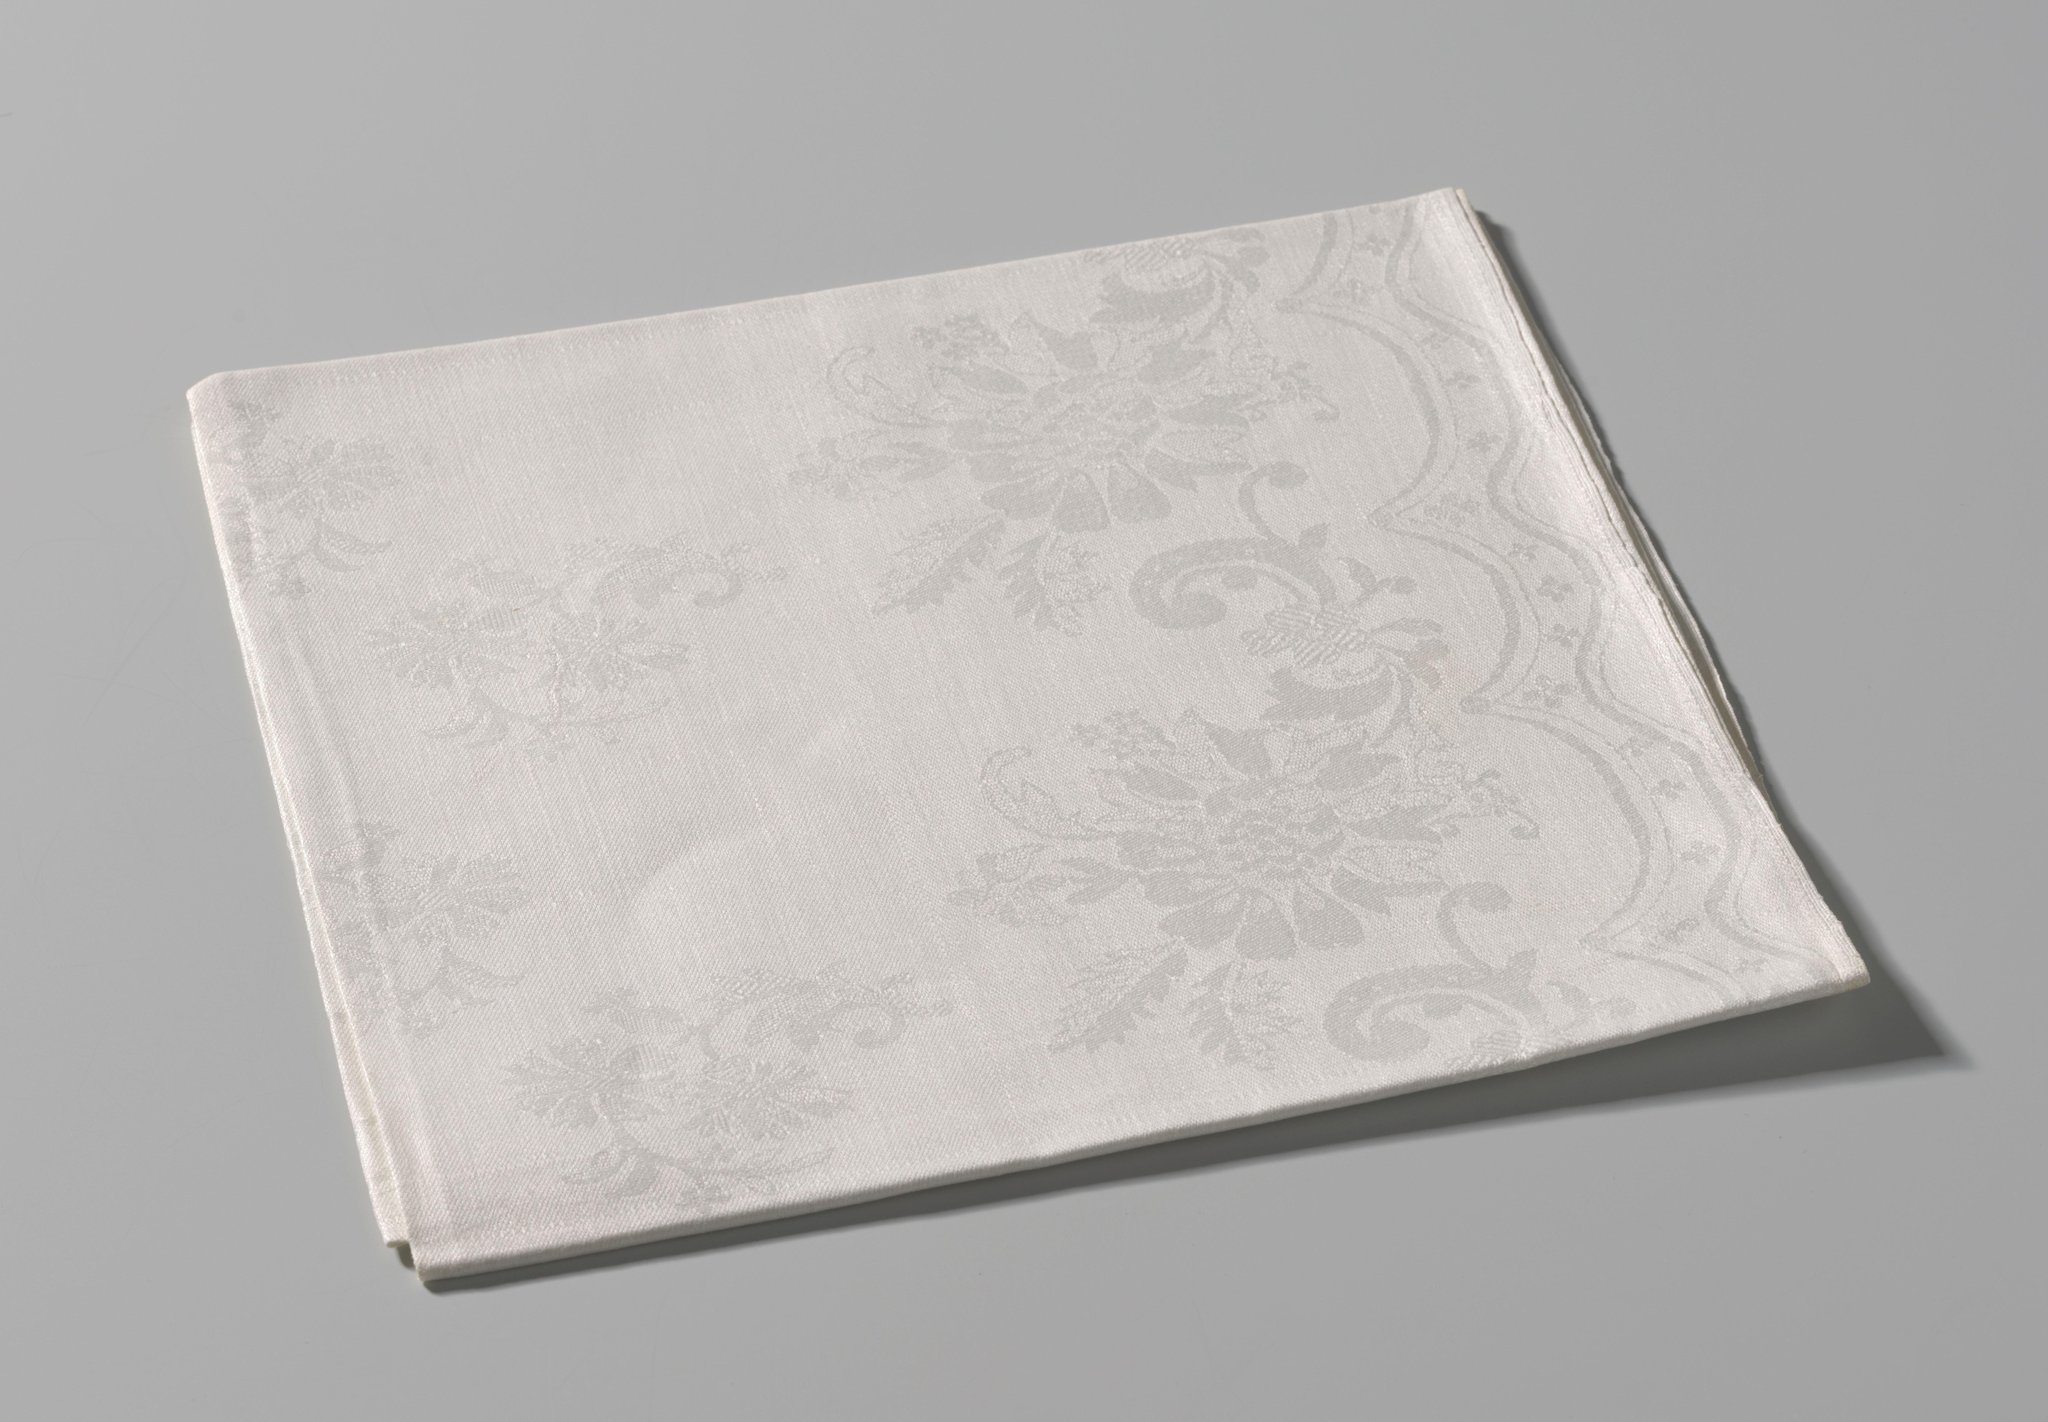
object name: napkin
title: Servet van wit linnendamast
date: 1859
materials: linen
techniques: damask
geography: borne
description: Wit linnen damasten servet met "hoorn", merk kroon H .